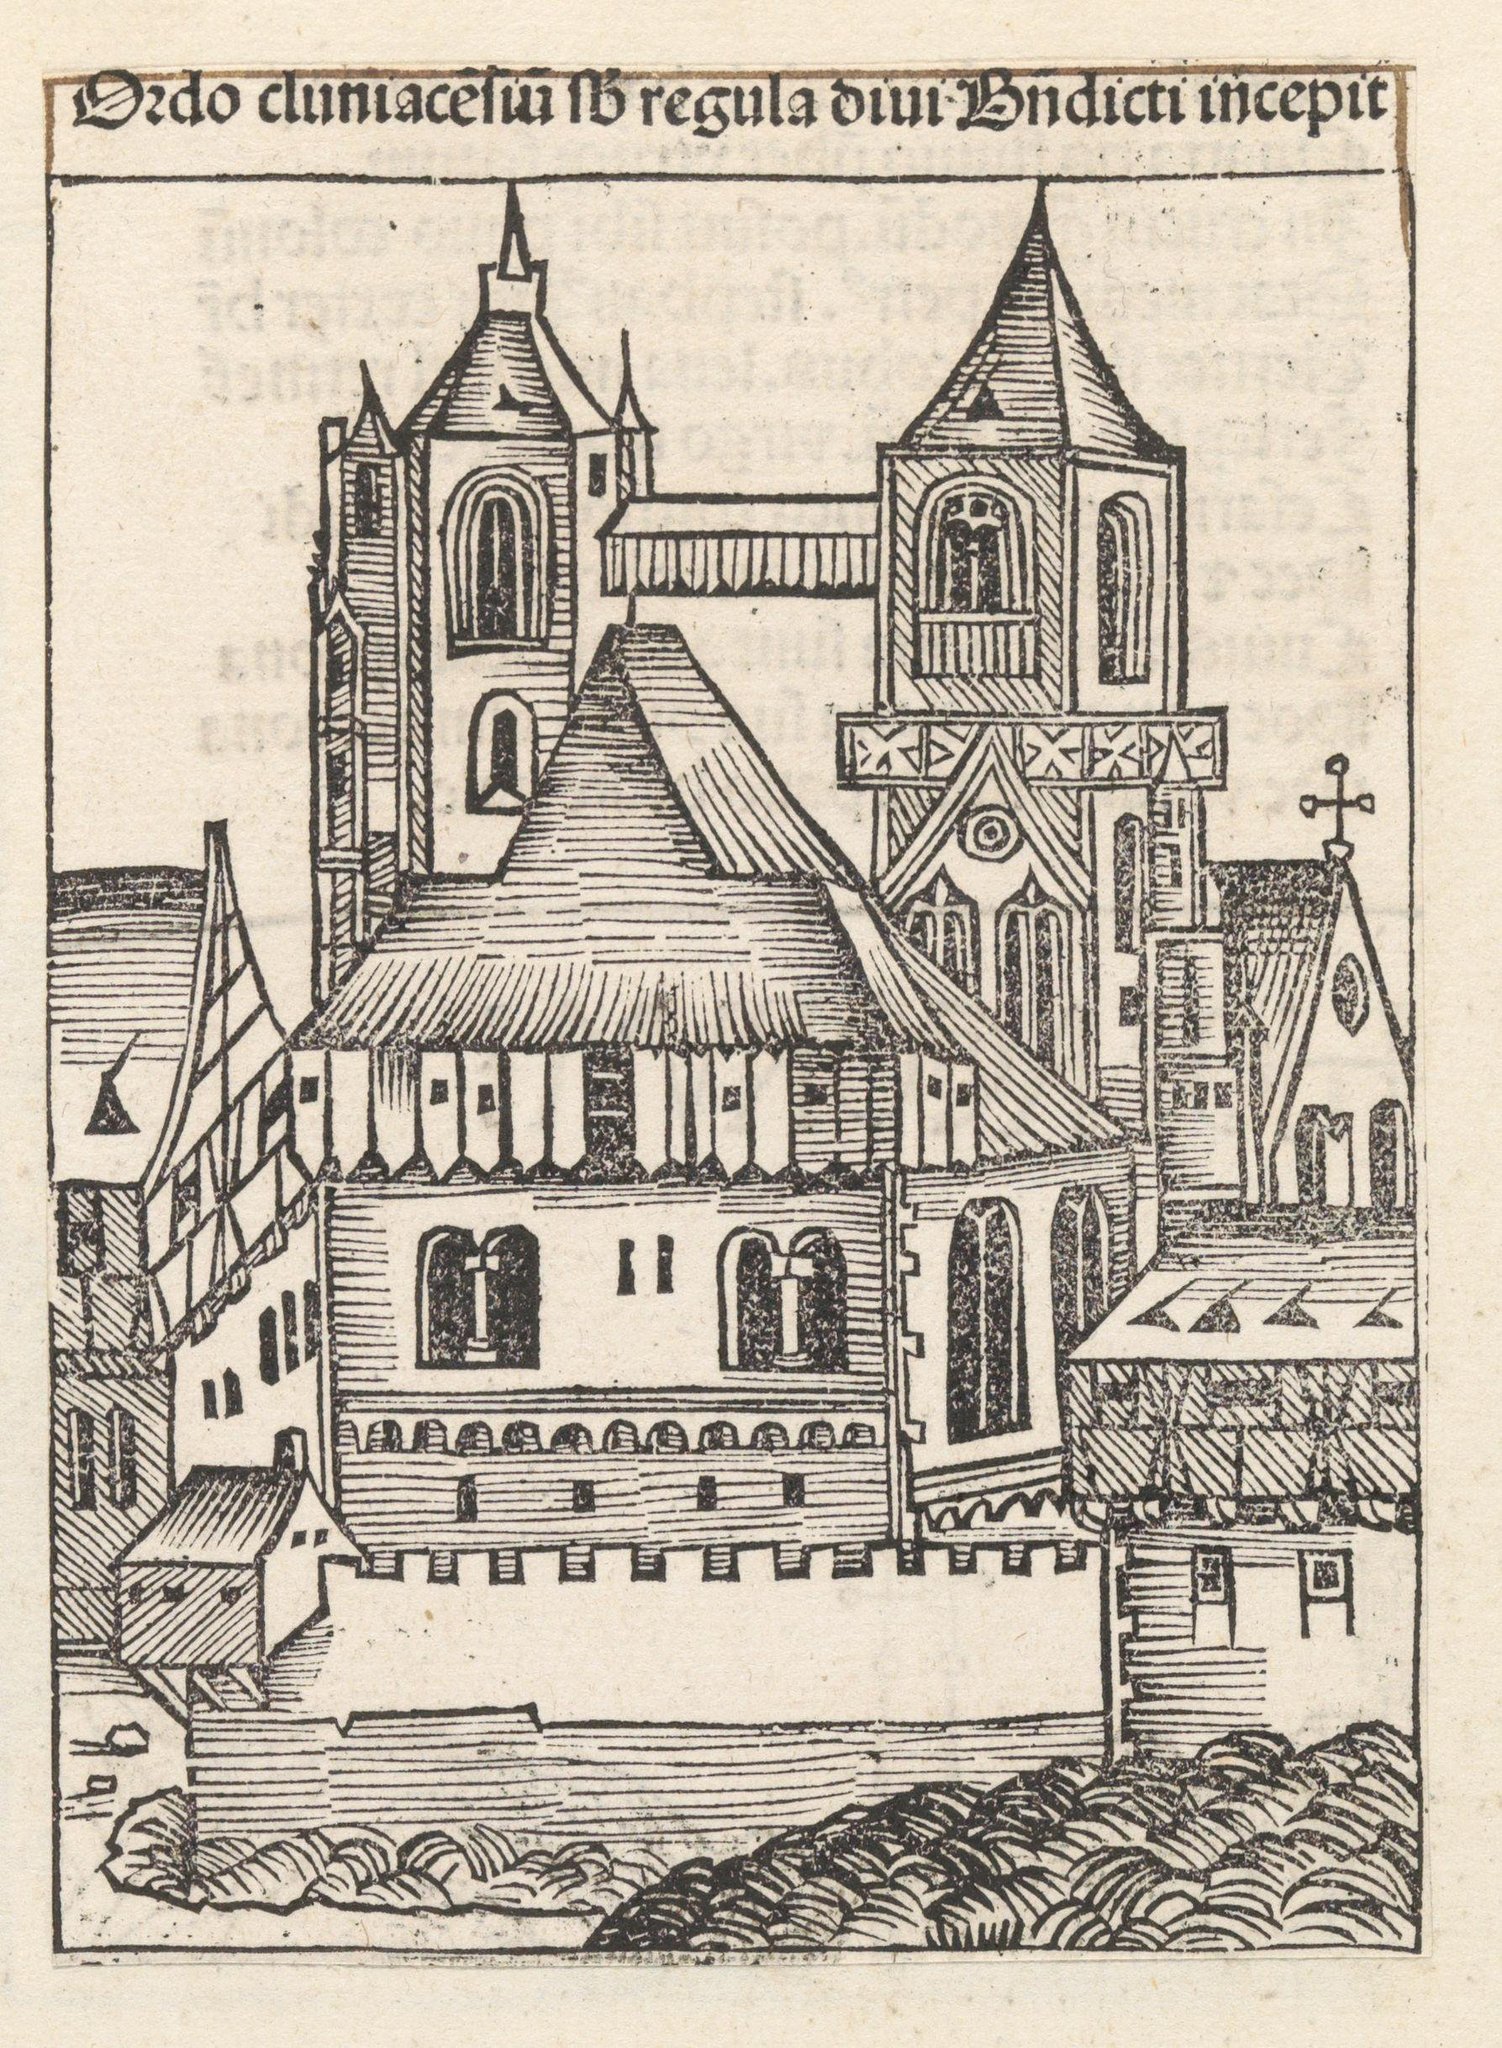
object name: print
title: Ordo cluniace[n]siu[m] (...)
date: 1493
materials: paper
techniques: letterpress printing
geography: nuremberg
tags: abbey, monastery, convent ~ roman catholic church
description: De houtsnede wordt herhaaldelijk gebruikt als boekillustratie in de Liber Chronicarum (of Neurenbergkroniek) van Hartmann Schedel, verschenen in het Latijn en Duits in 1493. Zie de Latijnse uitgave, folio 175v.